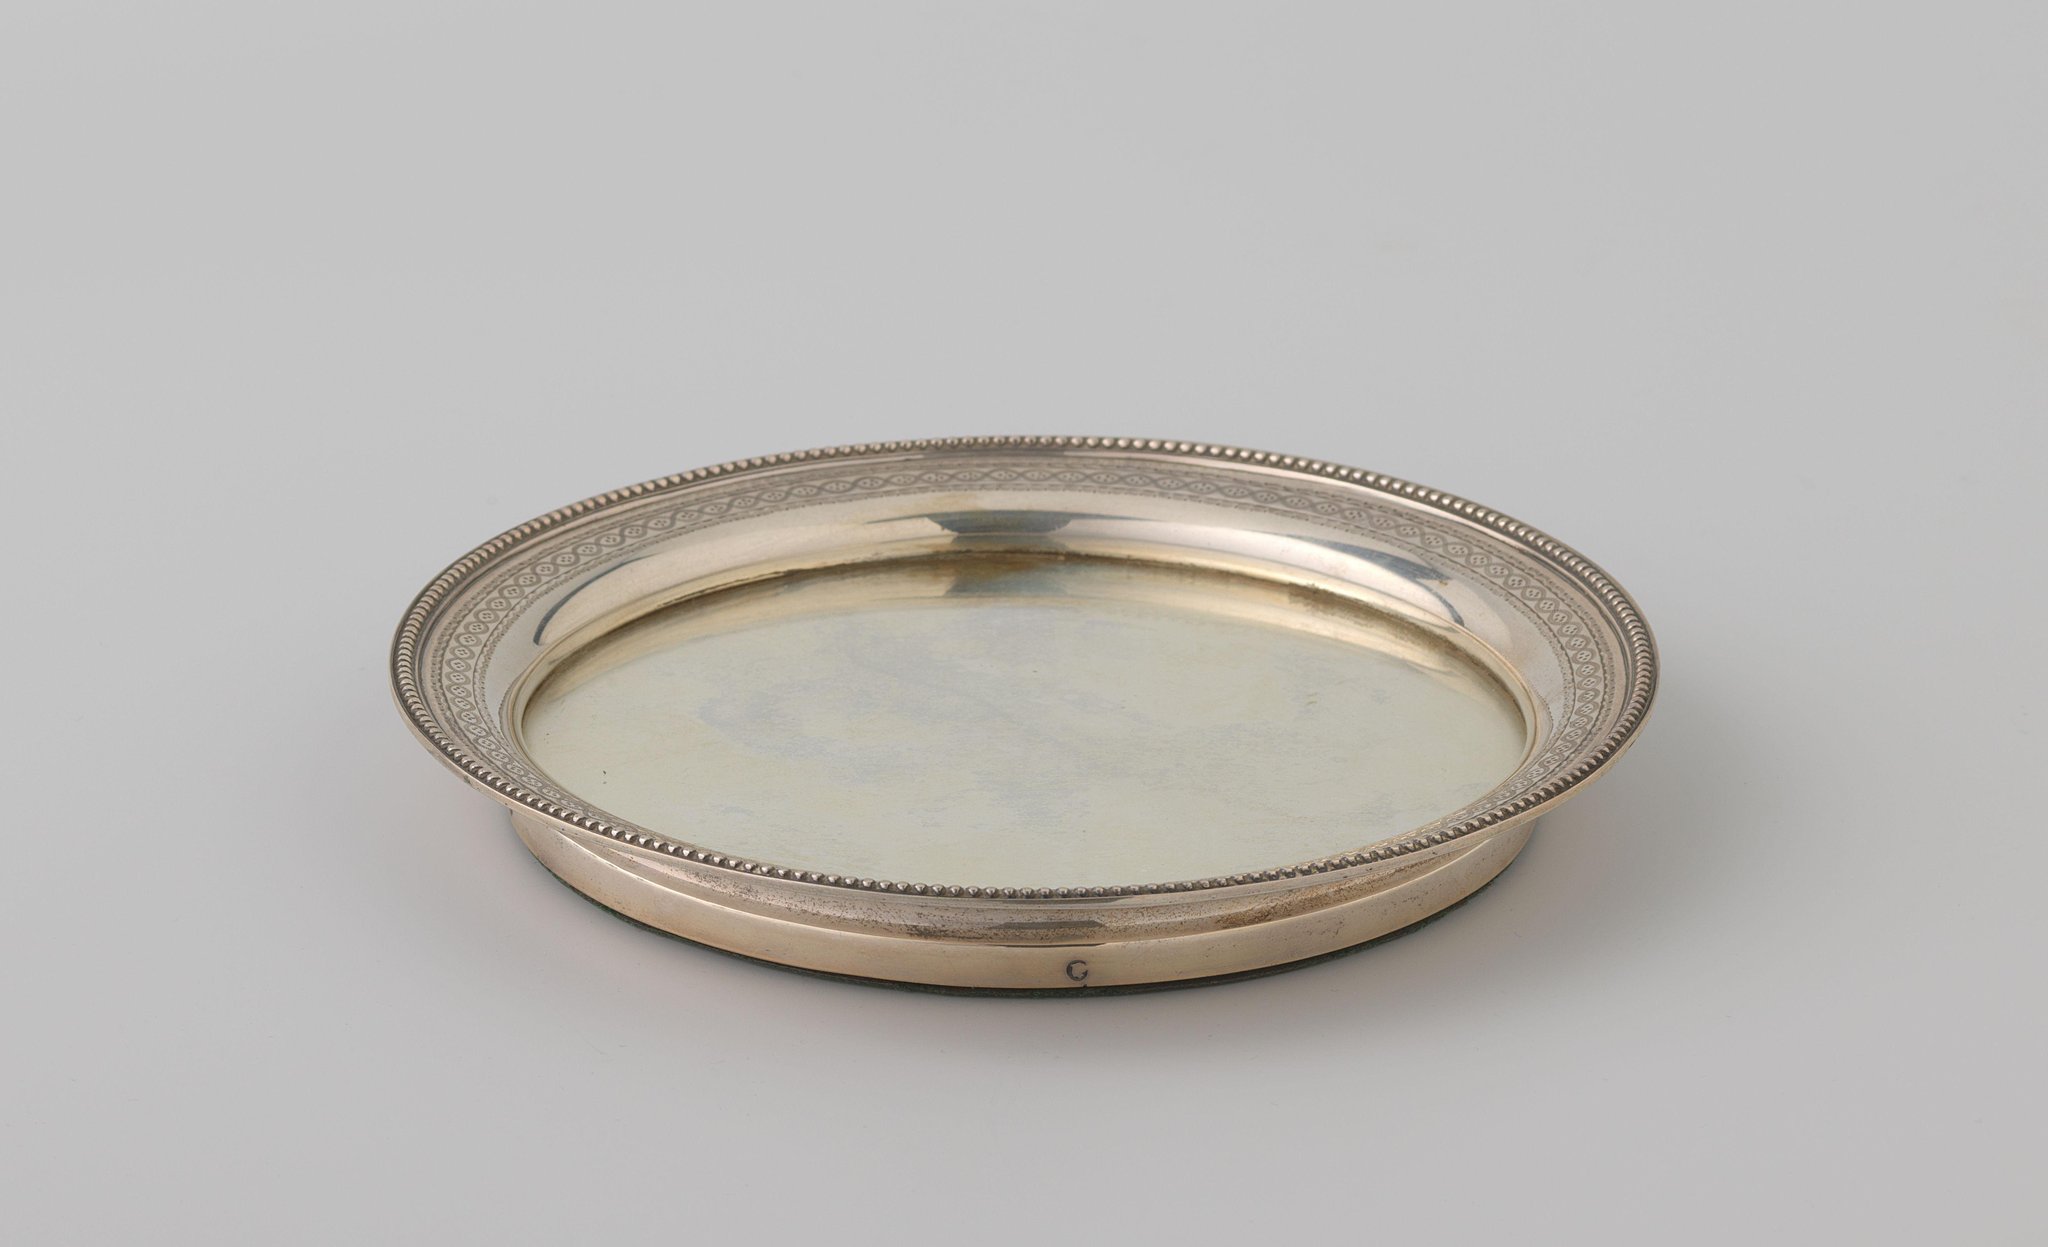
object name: blad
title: Blad van zilver, met bodem van spiegelglas. Parelrand en gegraveerde versieringen. Behoort bij koektrommel BK-KOG-2604-A-I.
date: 1891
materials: silver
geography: netherlands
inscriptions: mark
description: Two boxes. Silver. Amsterdam, 1788, by Johannes Logerath. On loan from the Koninklijk Oudheidkundig Genootschap.